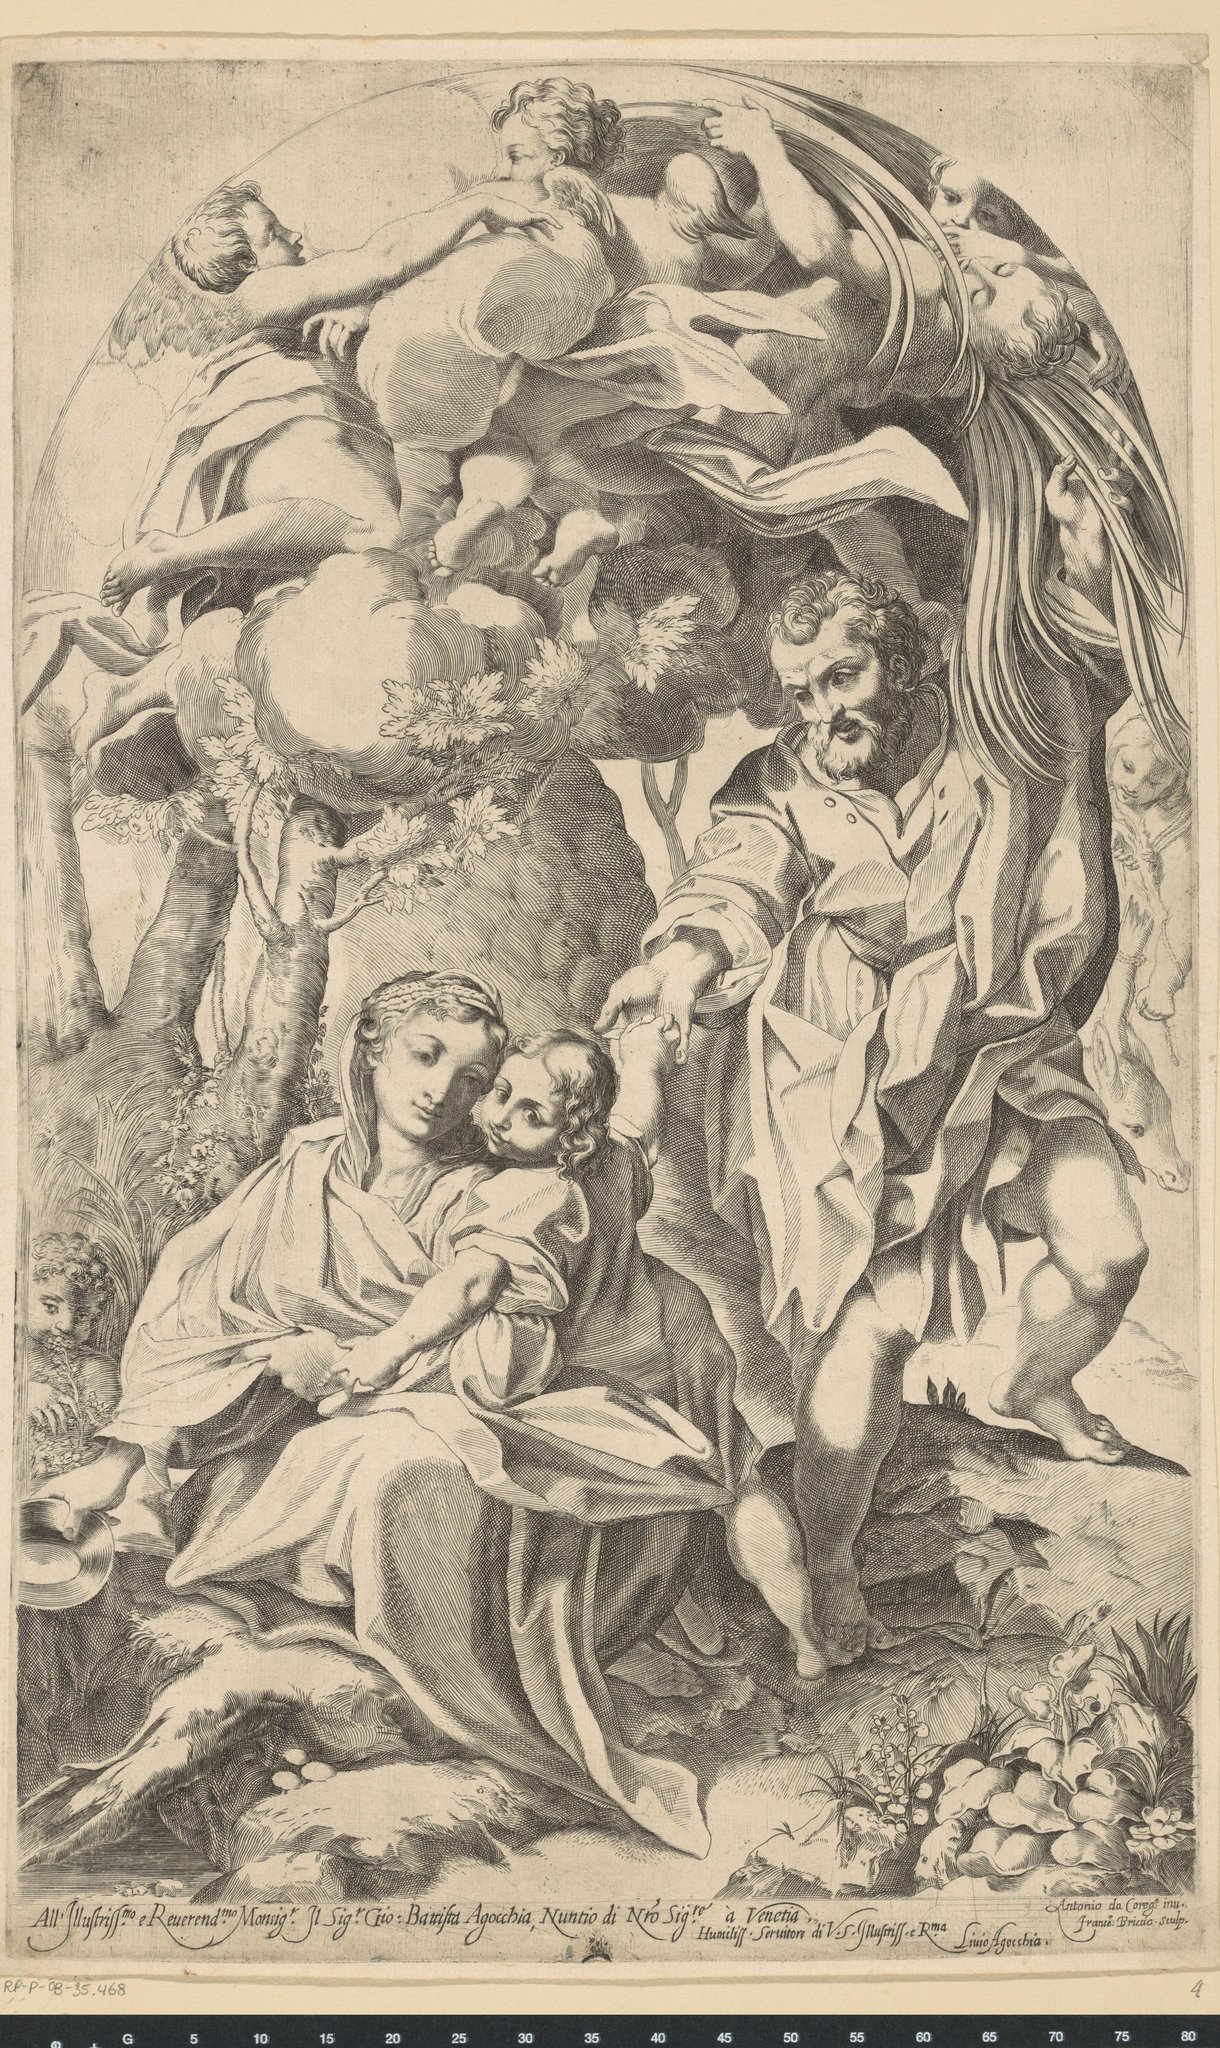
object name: print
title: Heilige Familie bij een bron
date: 1584-1623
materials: paper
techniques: engraving, etching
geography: italy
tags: holy family, and derived representations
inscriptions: collector's mark: Lugt 240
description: Maria zit bij een bron. Het Christuskind leunt tegen haar aan. Jozef staat rechts. Boven zweven engelen. Tekst in ondermarge.